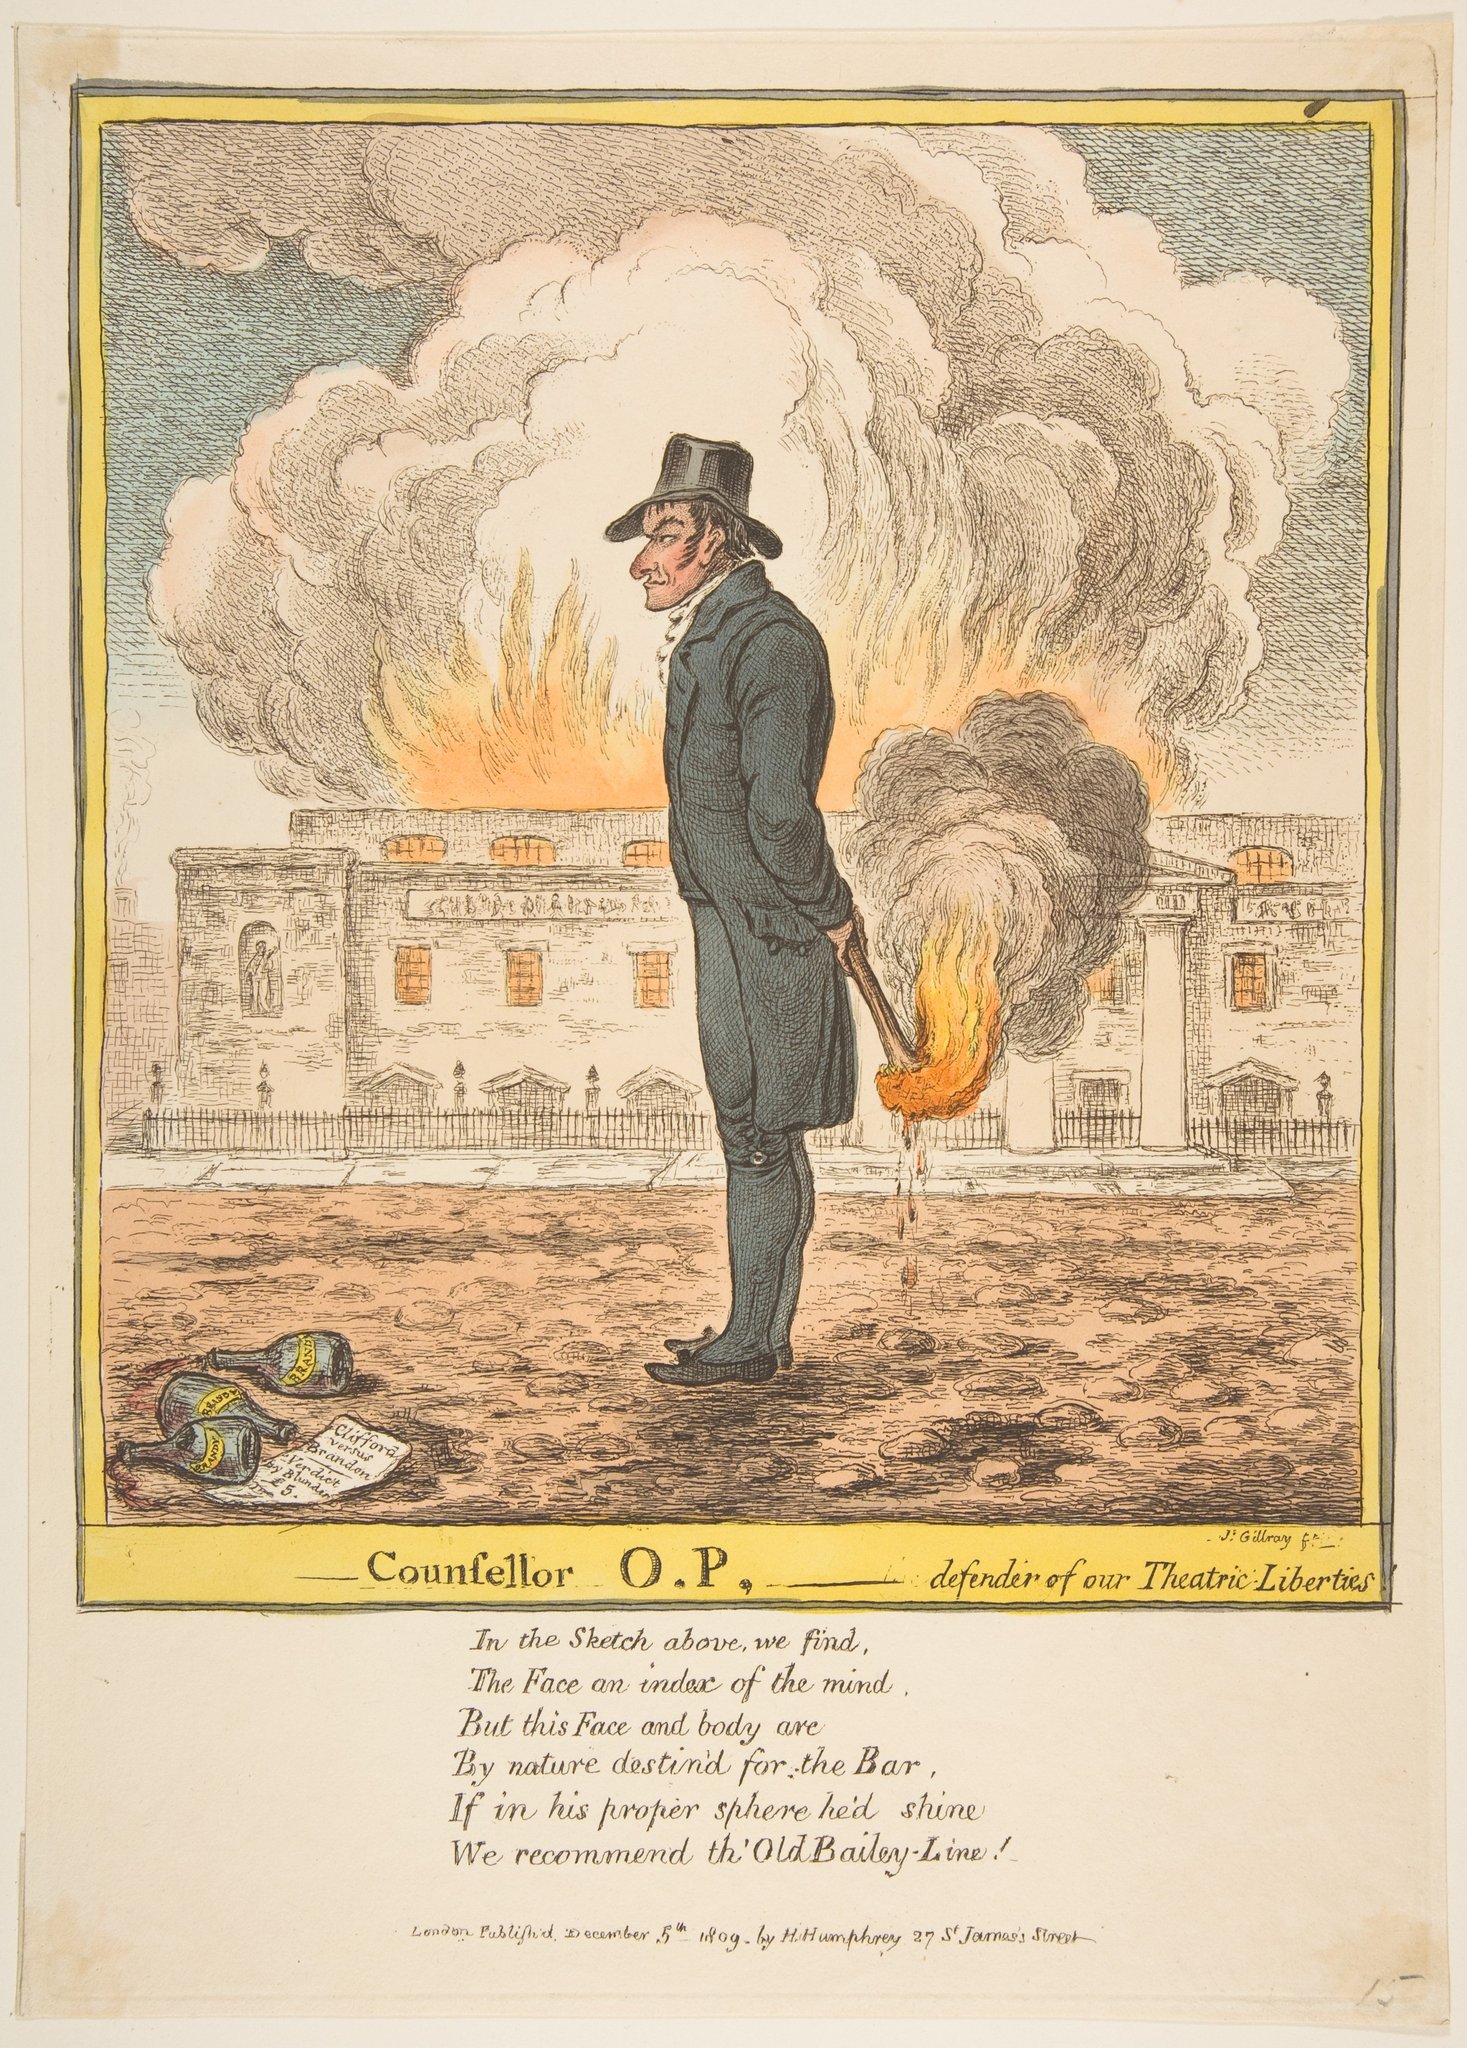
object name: print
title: Counsellor O.P.–Defender of our Theatric Liberties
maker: james gillray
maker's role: artist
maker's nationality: british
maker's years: 1756-1815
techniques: etching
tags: buildings,men,fire